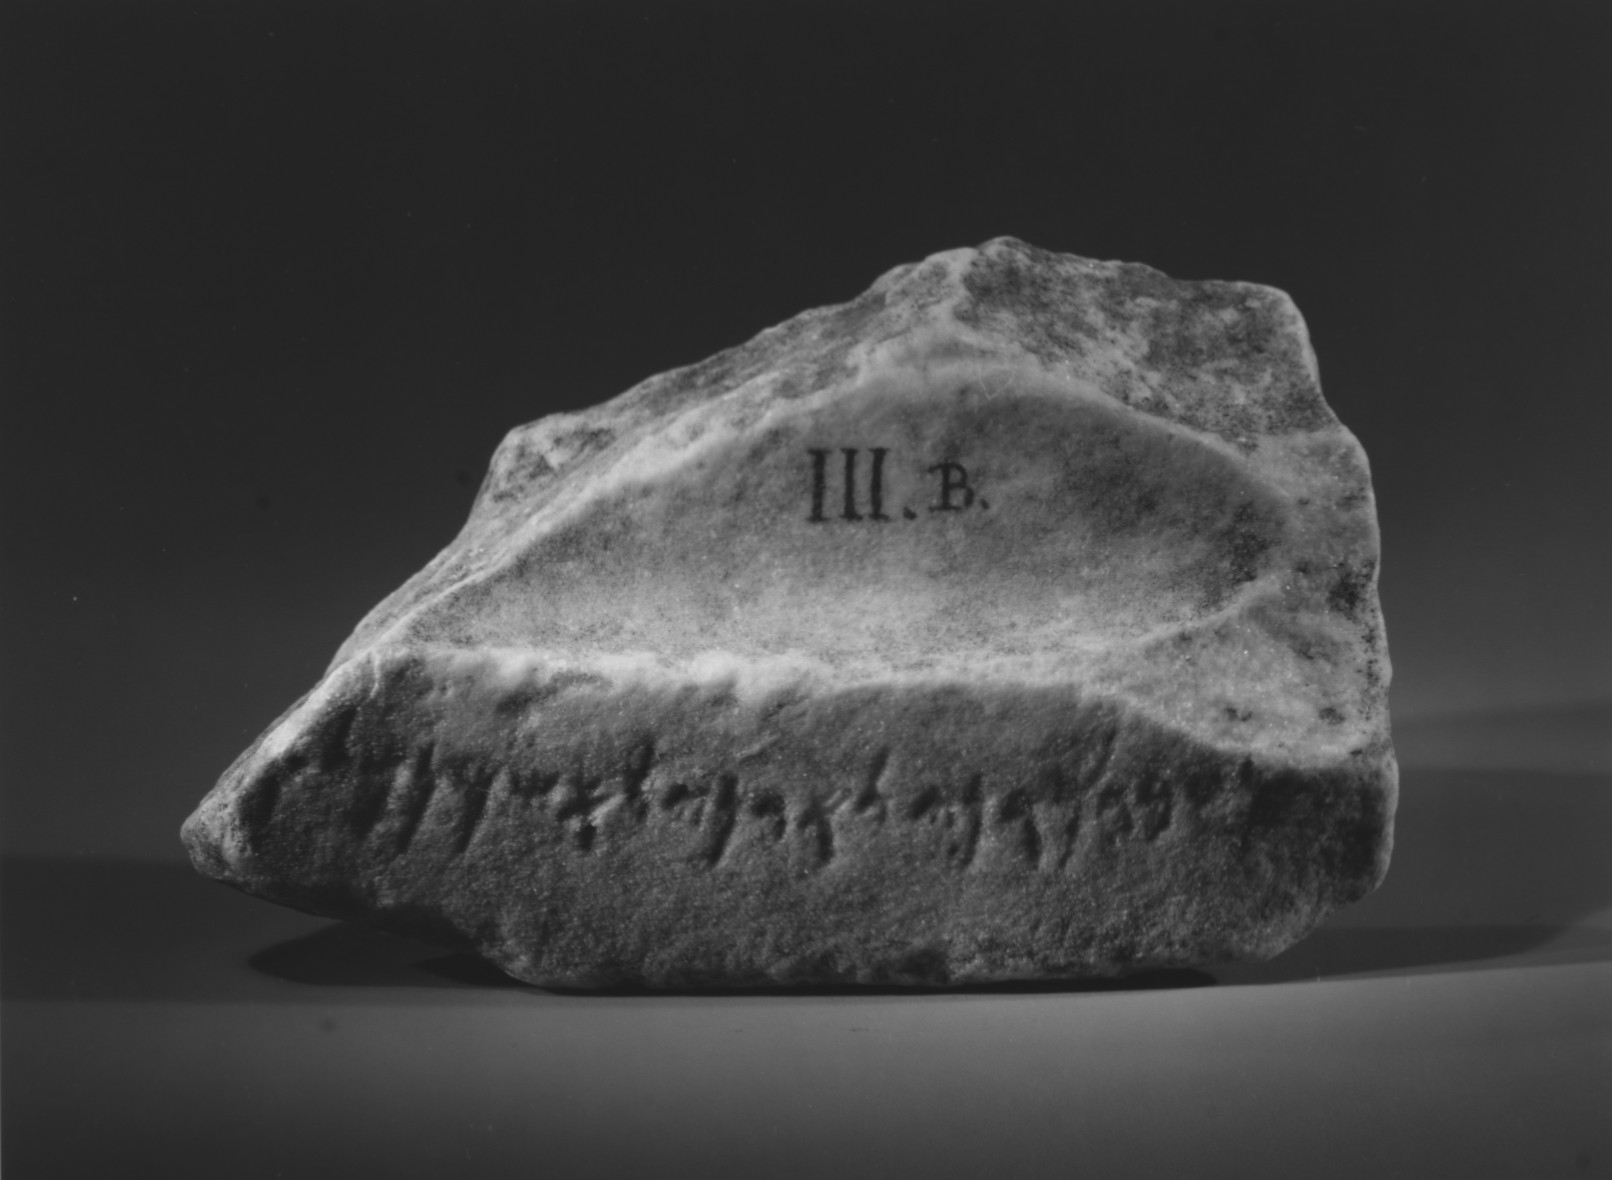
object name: bowl, fragmentary, phoenician inscription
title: Marble bowl fragment with Phoenician inscription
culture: cypriot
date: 389 BCE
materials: marble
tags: phoenician